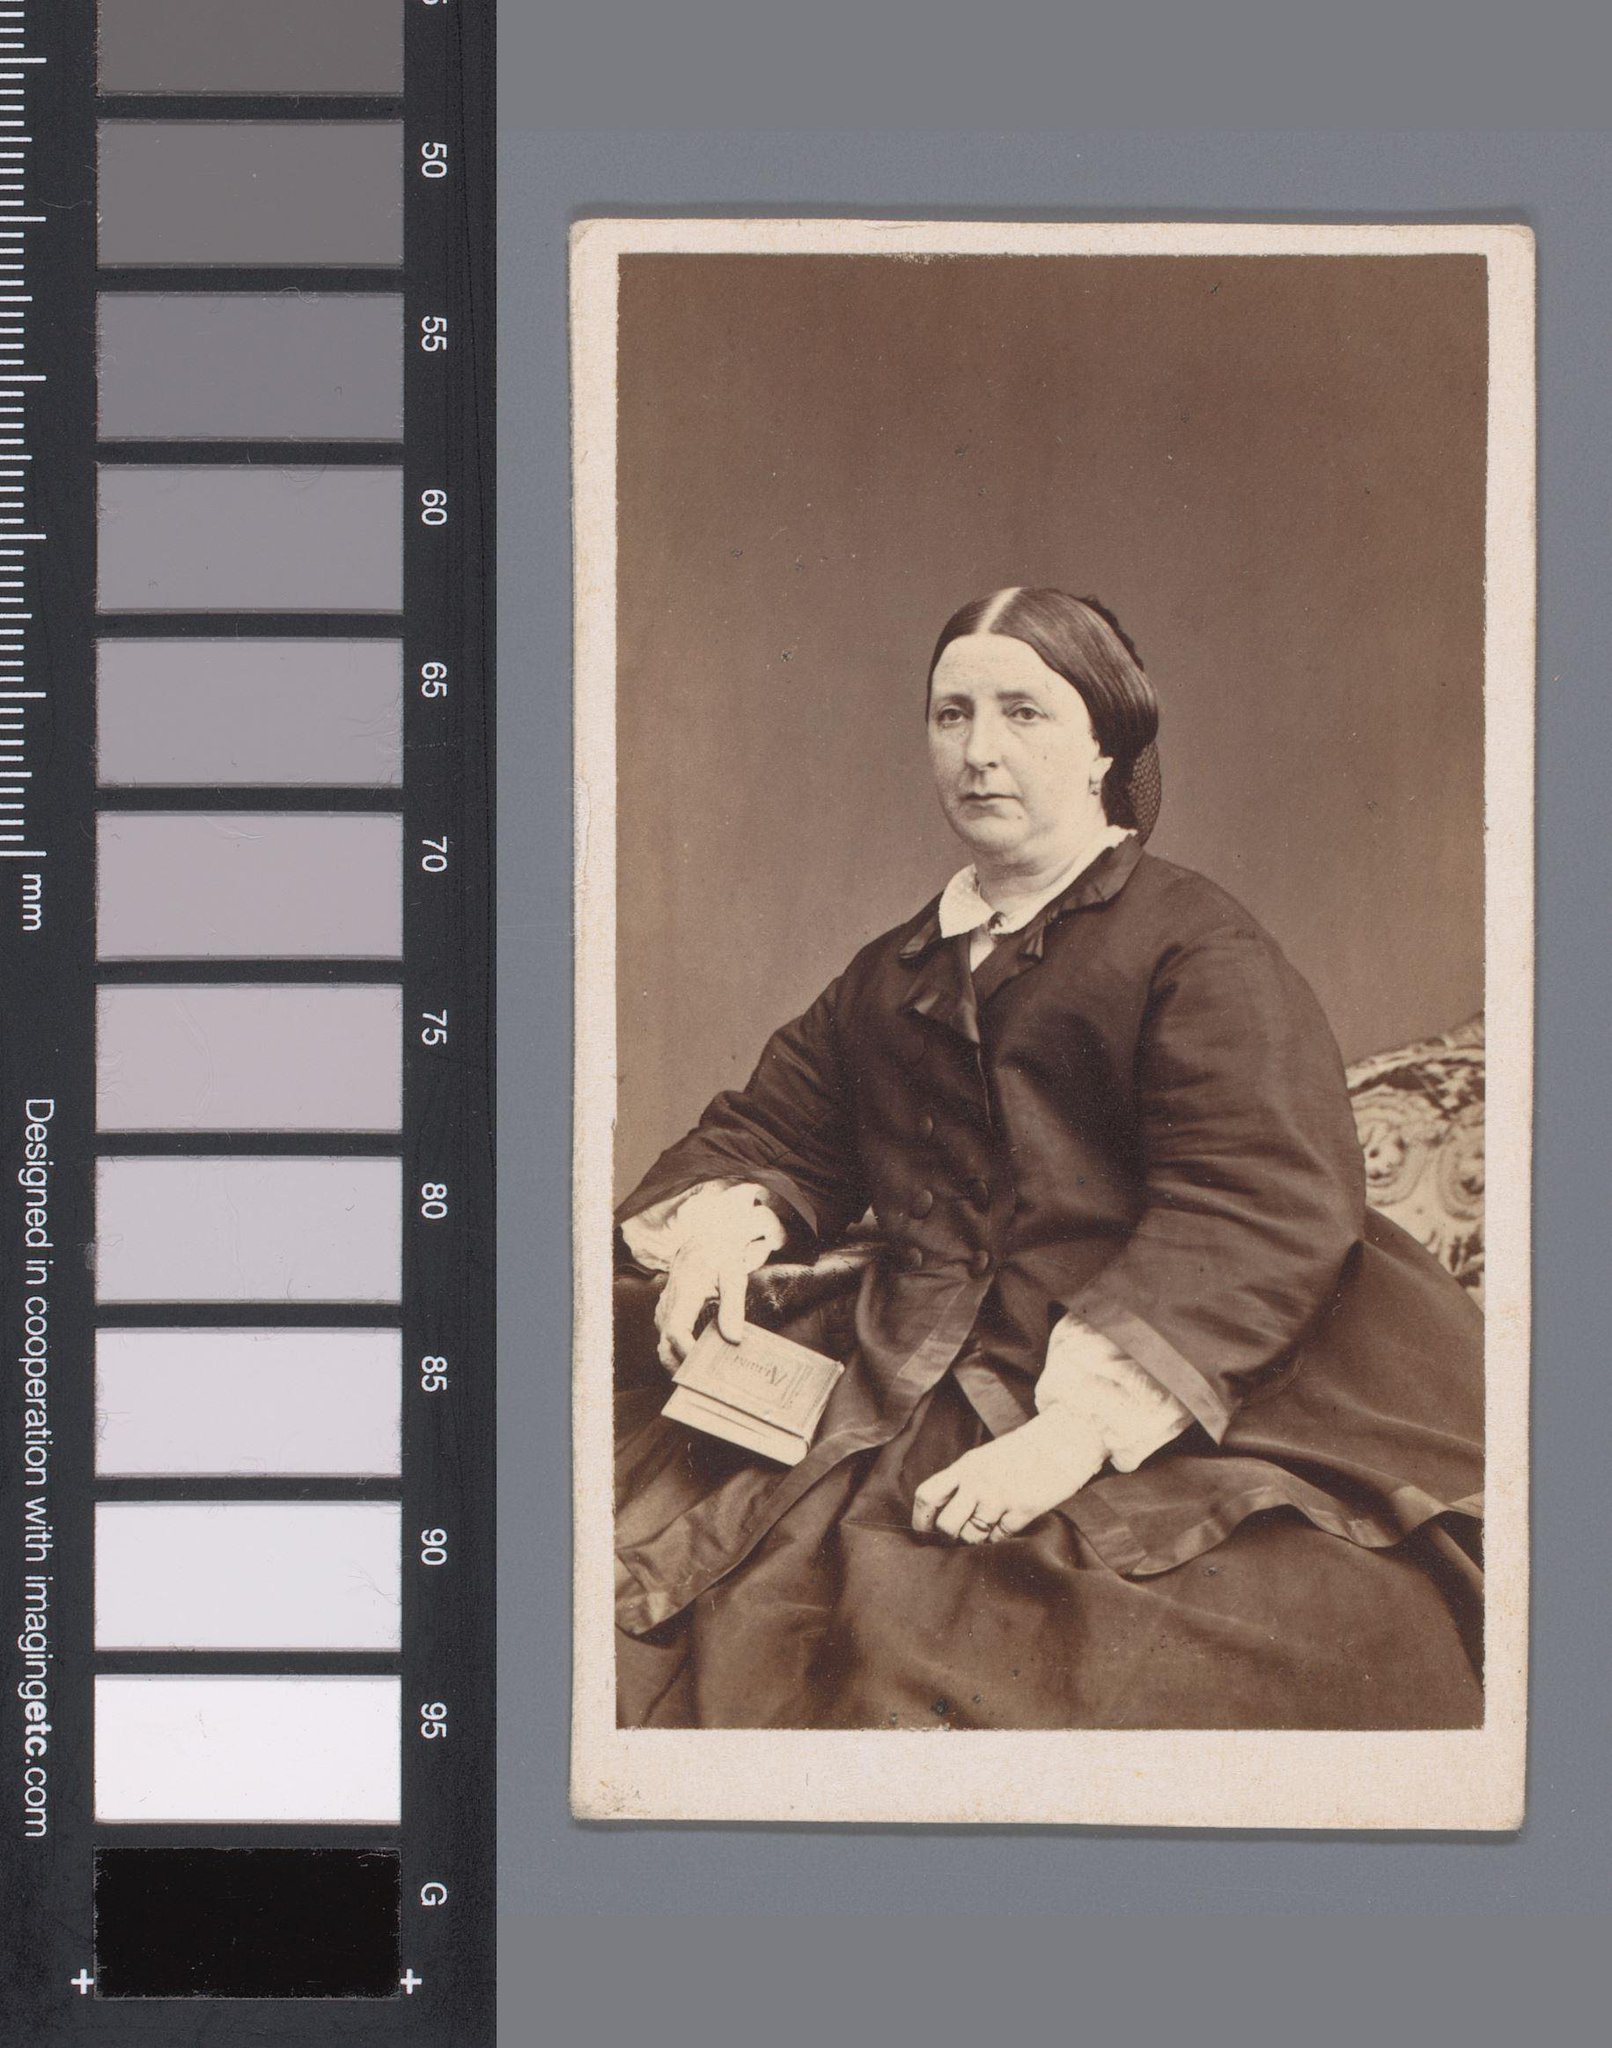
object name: photograph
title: Portret van een onbekende zittende vrouw met een boek in haar hand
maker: carl jacob malmberg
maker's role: fotograaf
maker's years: 1824-1895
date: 1861-1870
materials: cardboard, paper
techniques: albumen print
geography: stockholm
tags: sitting figure - aa - female human figure, historical persons - bb - woman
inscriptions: inscription: ‘C.J. MALMBERG/ FOTOGRAF/ 40 DROTTNINGGATAN N40/ STOCKHOLM.’